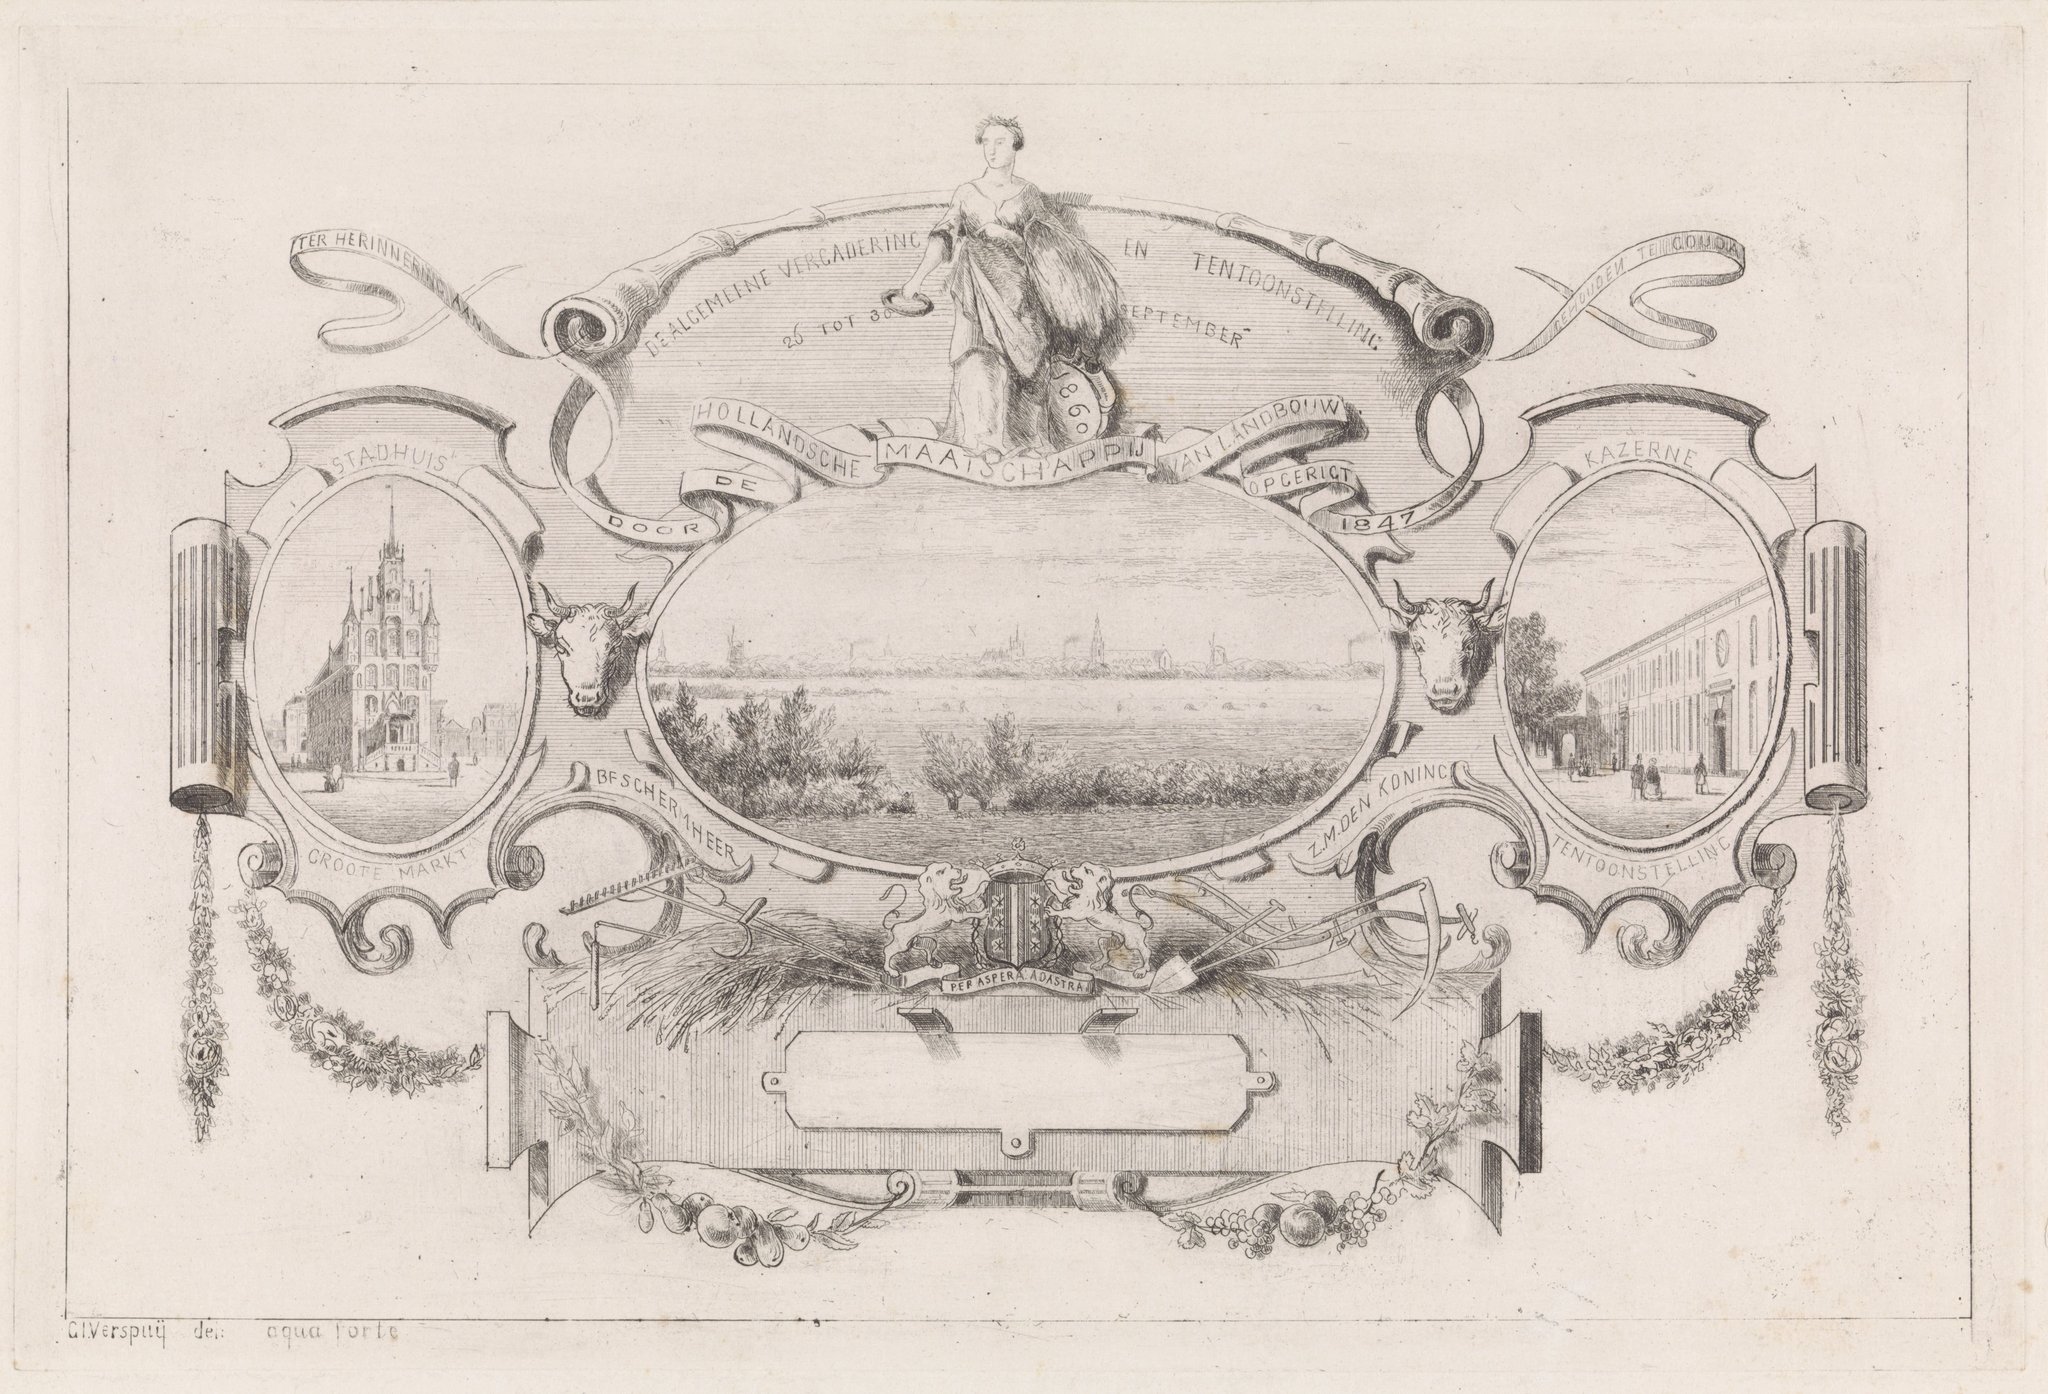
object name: print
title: Herinnering aan de landbouwkundige vergadering en tentoonstelling te Gouda, 1860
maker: gijsbertus johannes verspuy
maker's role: print maker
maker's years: 1823-1862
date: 1860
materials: paper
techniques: etching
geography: netherlands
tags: agricultural implements, personification of agriculture, 'agricultura'; 'agricoltura', 'studio dell'agricoltura' (ripa), prospect of city, town panorama, silhouette of city, gouda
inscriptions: collector's mark: Lugt 1485, collector's mark: Lugt 2228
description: Drie cartouches met links het stadhuis aan de grote markt te Gouda, in het midden een stadsprofiel van Gouda en rechts de karzerne van het garnizoen aan de Varkensmarkt te Gouda. Daarboven een allegorische vrouwenfiguur als personificatie van de landbouw en eronder het stadwapen geflankeerd door twee leeuwen. Daaronder een leeg tablet met attributen uit de landbouw en bloemen- en vruchtenguirlandes.